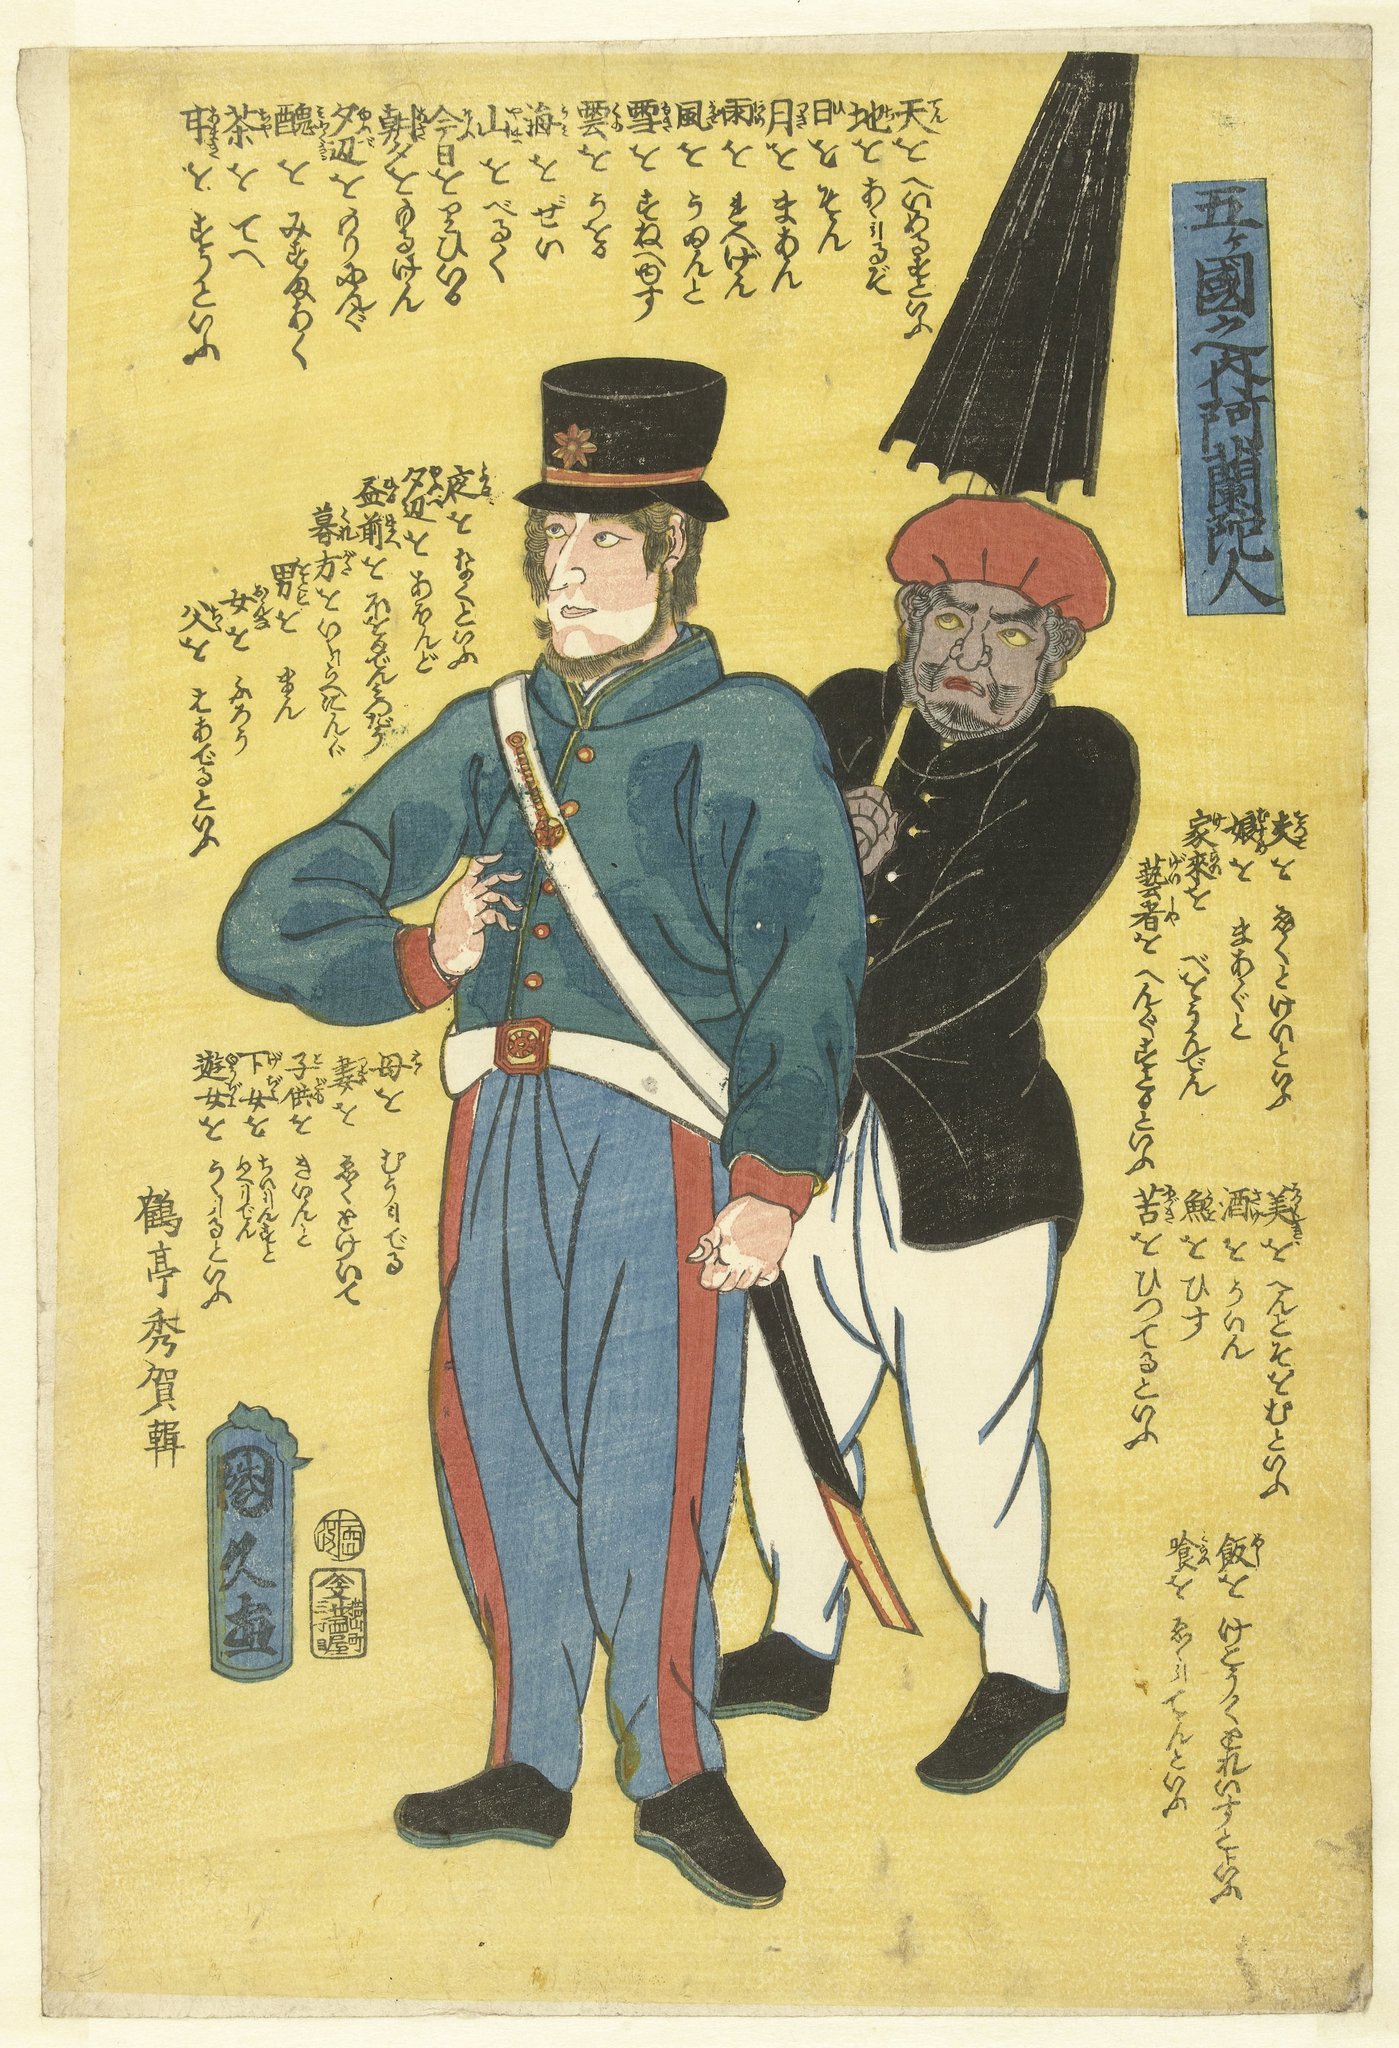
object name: print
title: Uit de vijf landen: de Hollander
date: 1810-1861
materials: paper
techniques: woodcut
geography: japan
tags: adult man (+ two persons), umbrella, house personnel, servants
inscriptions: collector's mark: Lugt 2228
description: Nederlander in uniform, gevolgd door Indische bediende met zwarte paraplu. De tekst op de gele achtergrond geeft (in het Japans) de Nederlandse uitpraak voor verschillende woorden die onder andere te maken hebben met familie, zoals 'moeder' en 'man' en natuurverschijnselen, zoals 'sneeuw' en 'wind'. (Yokohama-e)